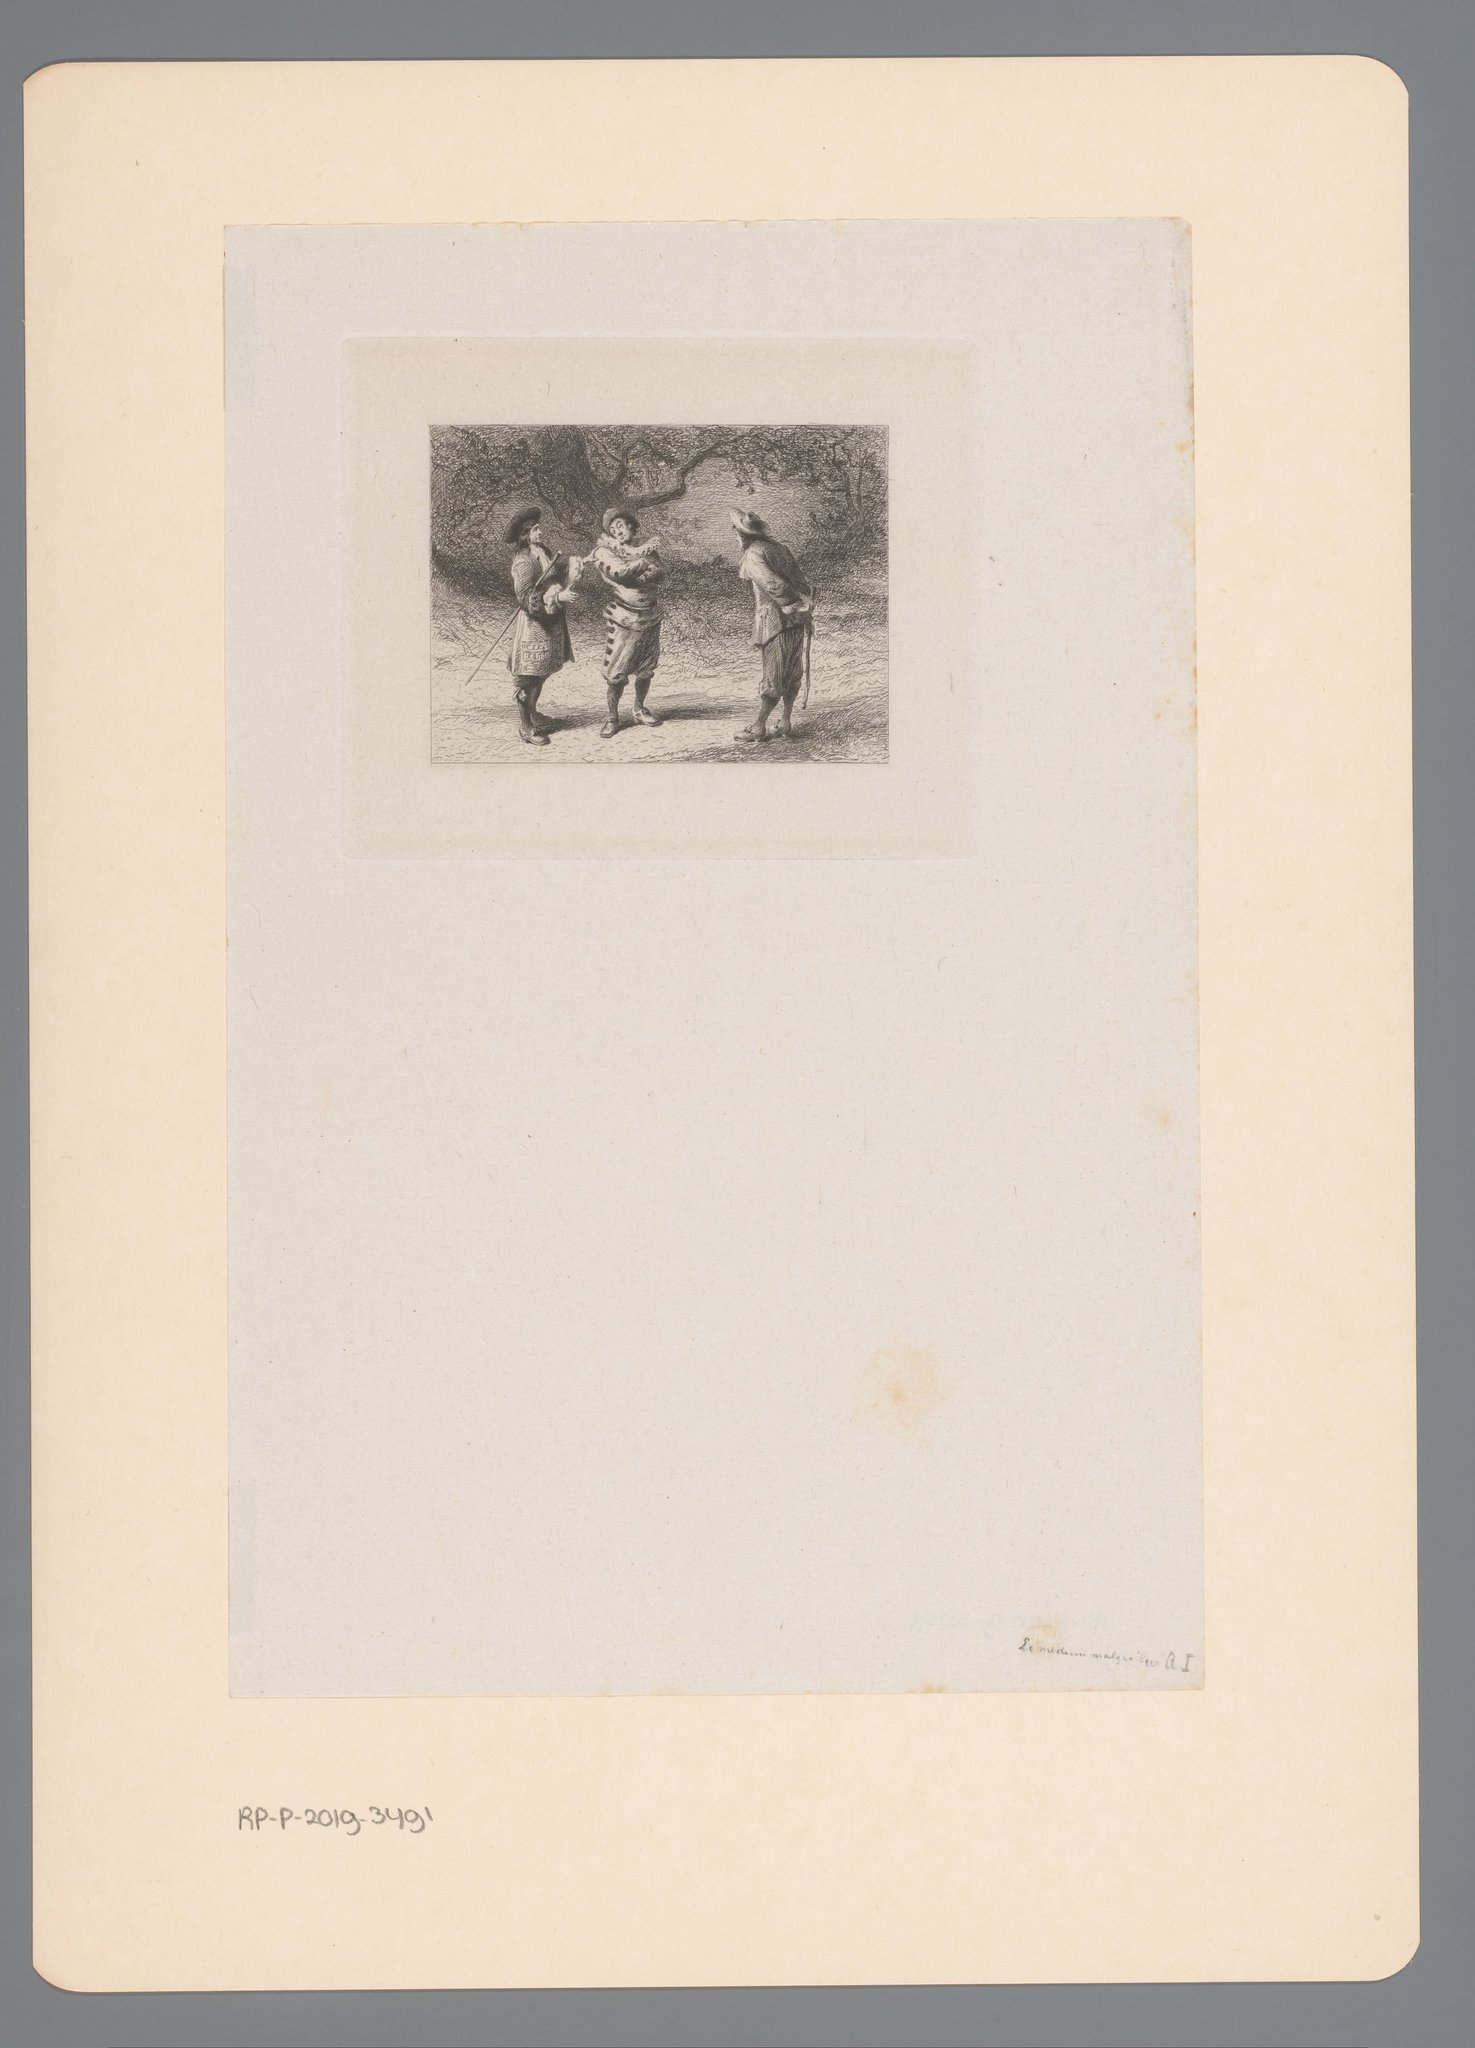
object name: print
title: Toneelstukken van Molière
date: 1878-1879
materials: paper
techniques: drypoint, etching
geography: tours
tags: theatre, theatrical performance, road, path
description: Akte I, scène V uit "Le Médecin Malgré Lui" van Molière.